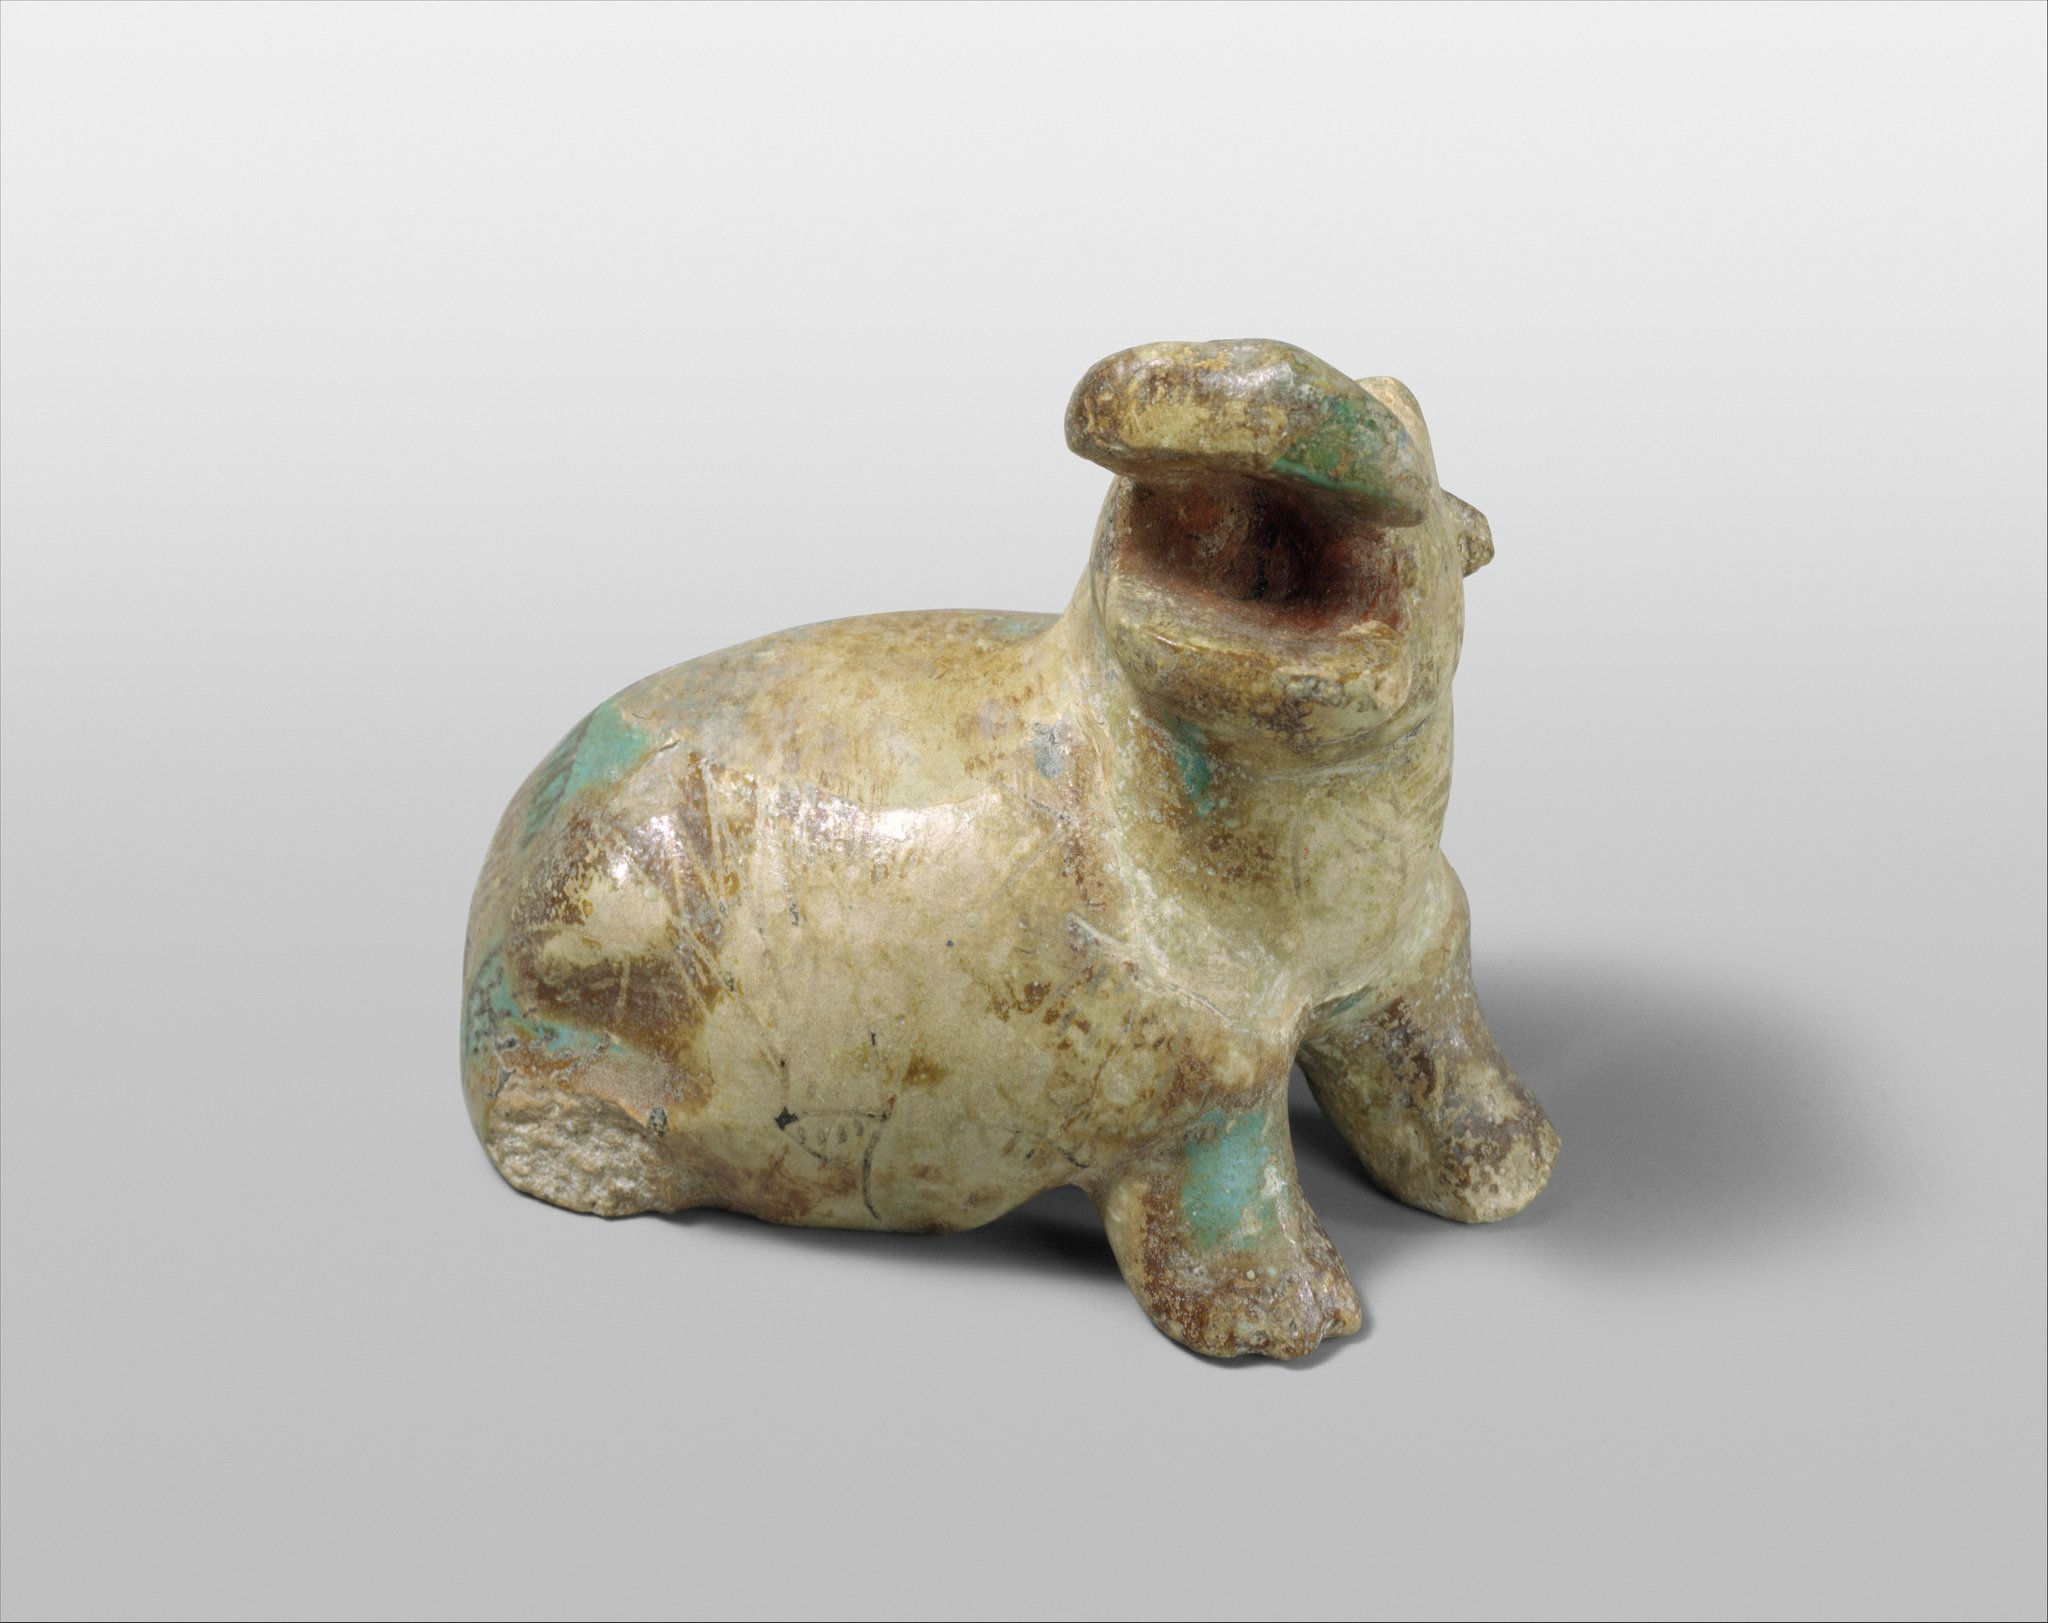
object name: figurine, hippopotamus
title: Hippopotamus figurine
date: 1850-1700 BCE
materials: faience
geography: egypt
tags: hippos